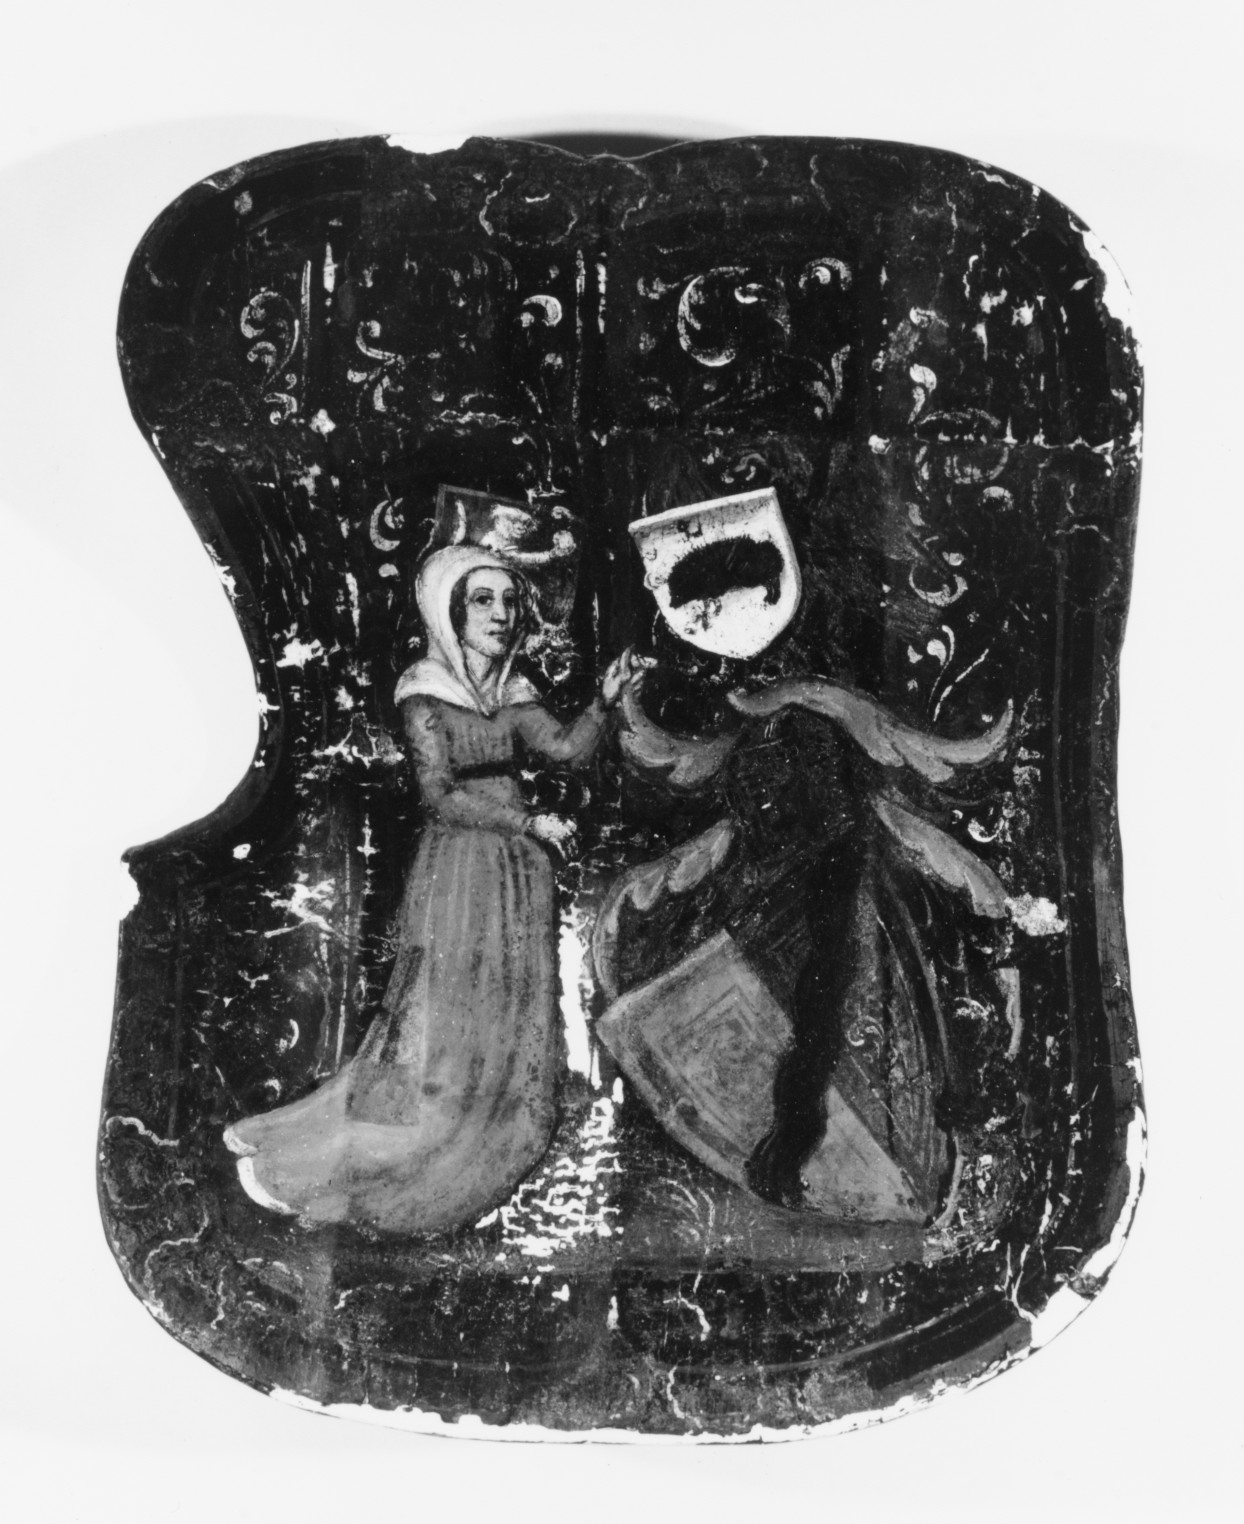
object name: shield for the field or tournament targe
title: Shield for the Field or Tournament (Targe)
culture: german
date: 1450-1500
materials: gesso, iron, leather, silver, wood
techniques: polychromy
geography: germany